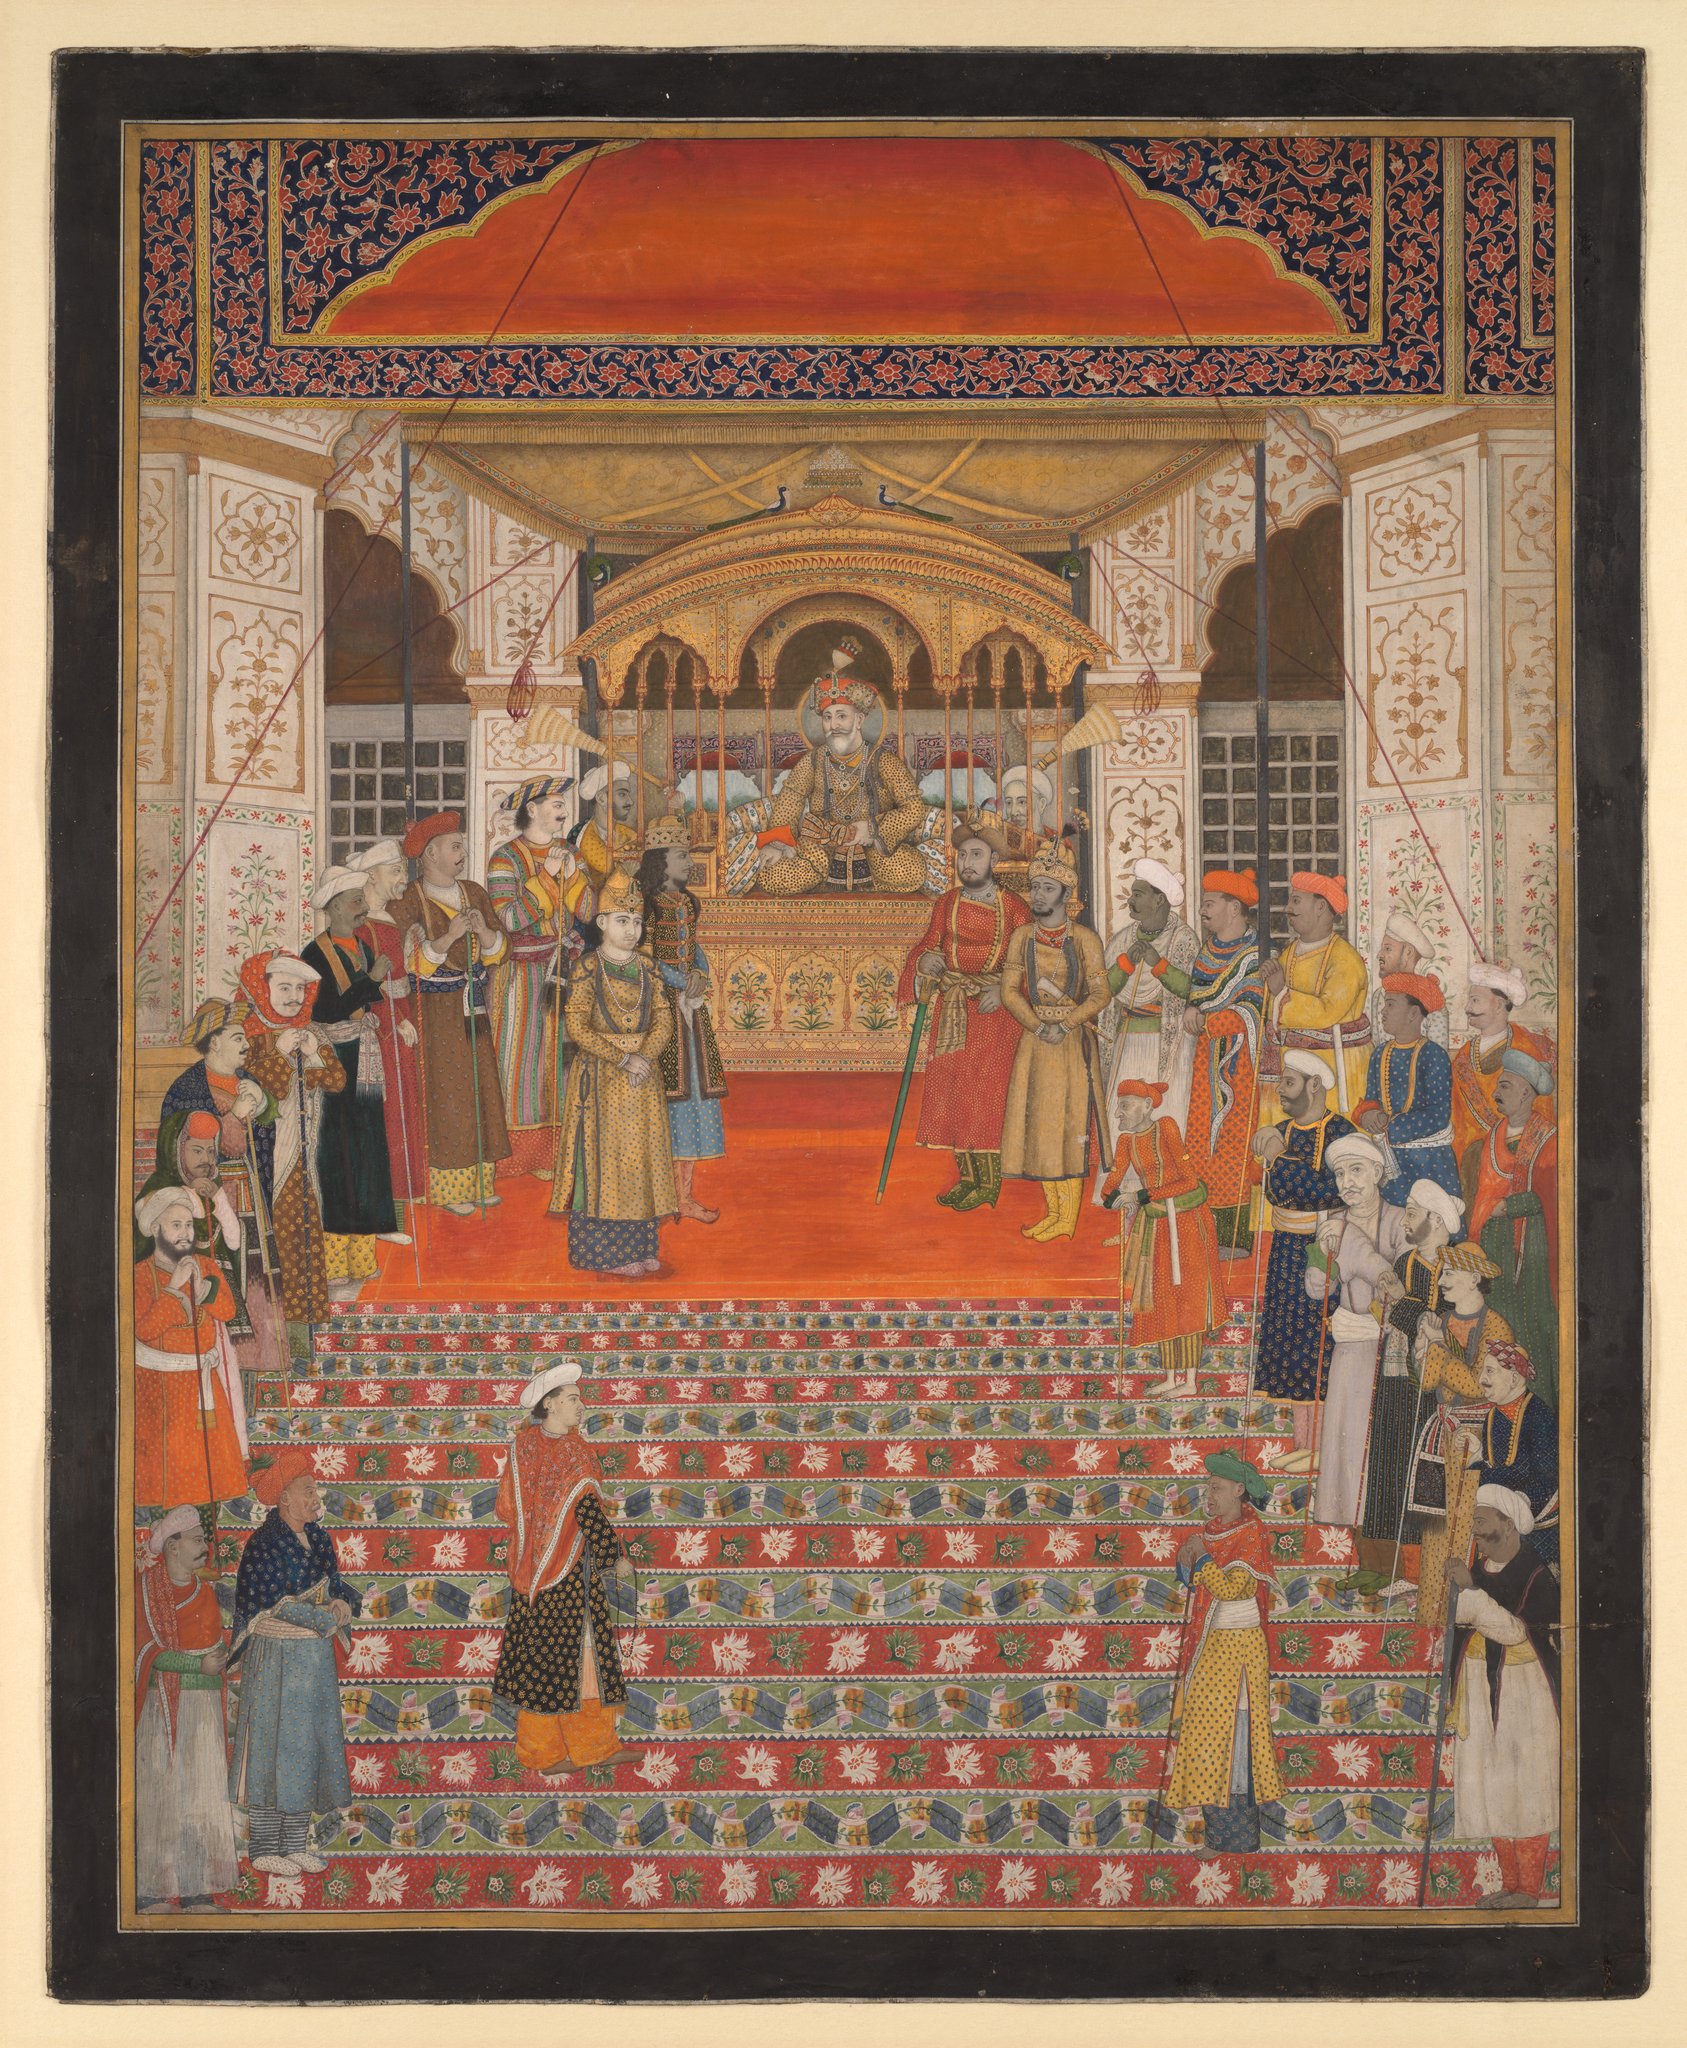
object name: illustrated single work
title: Durbar of Emperor Akbar Shah II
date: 1820-1830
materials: gold, paper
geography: india